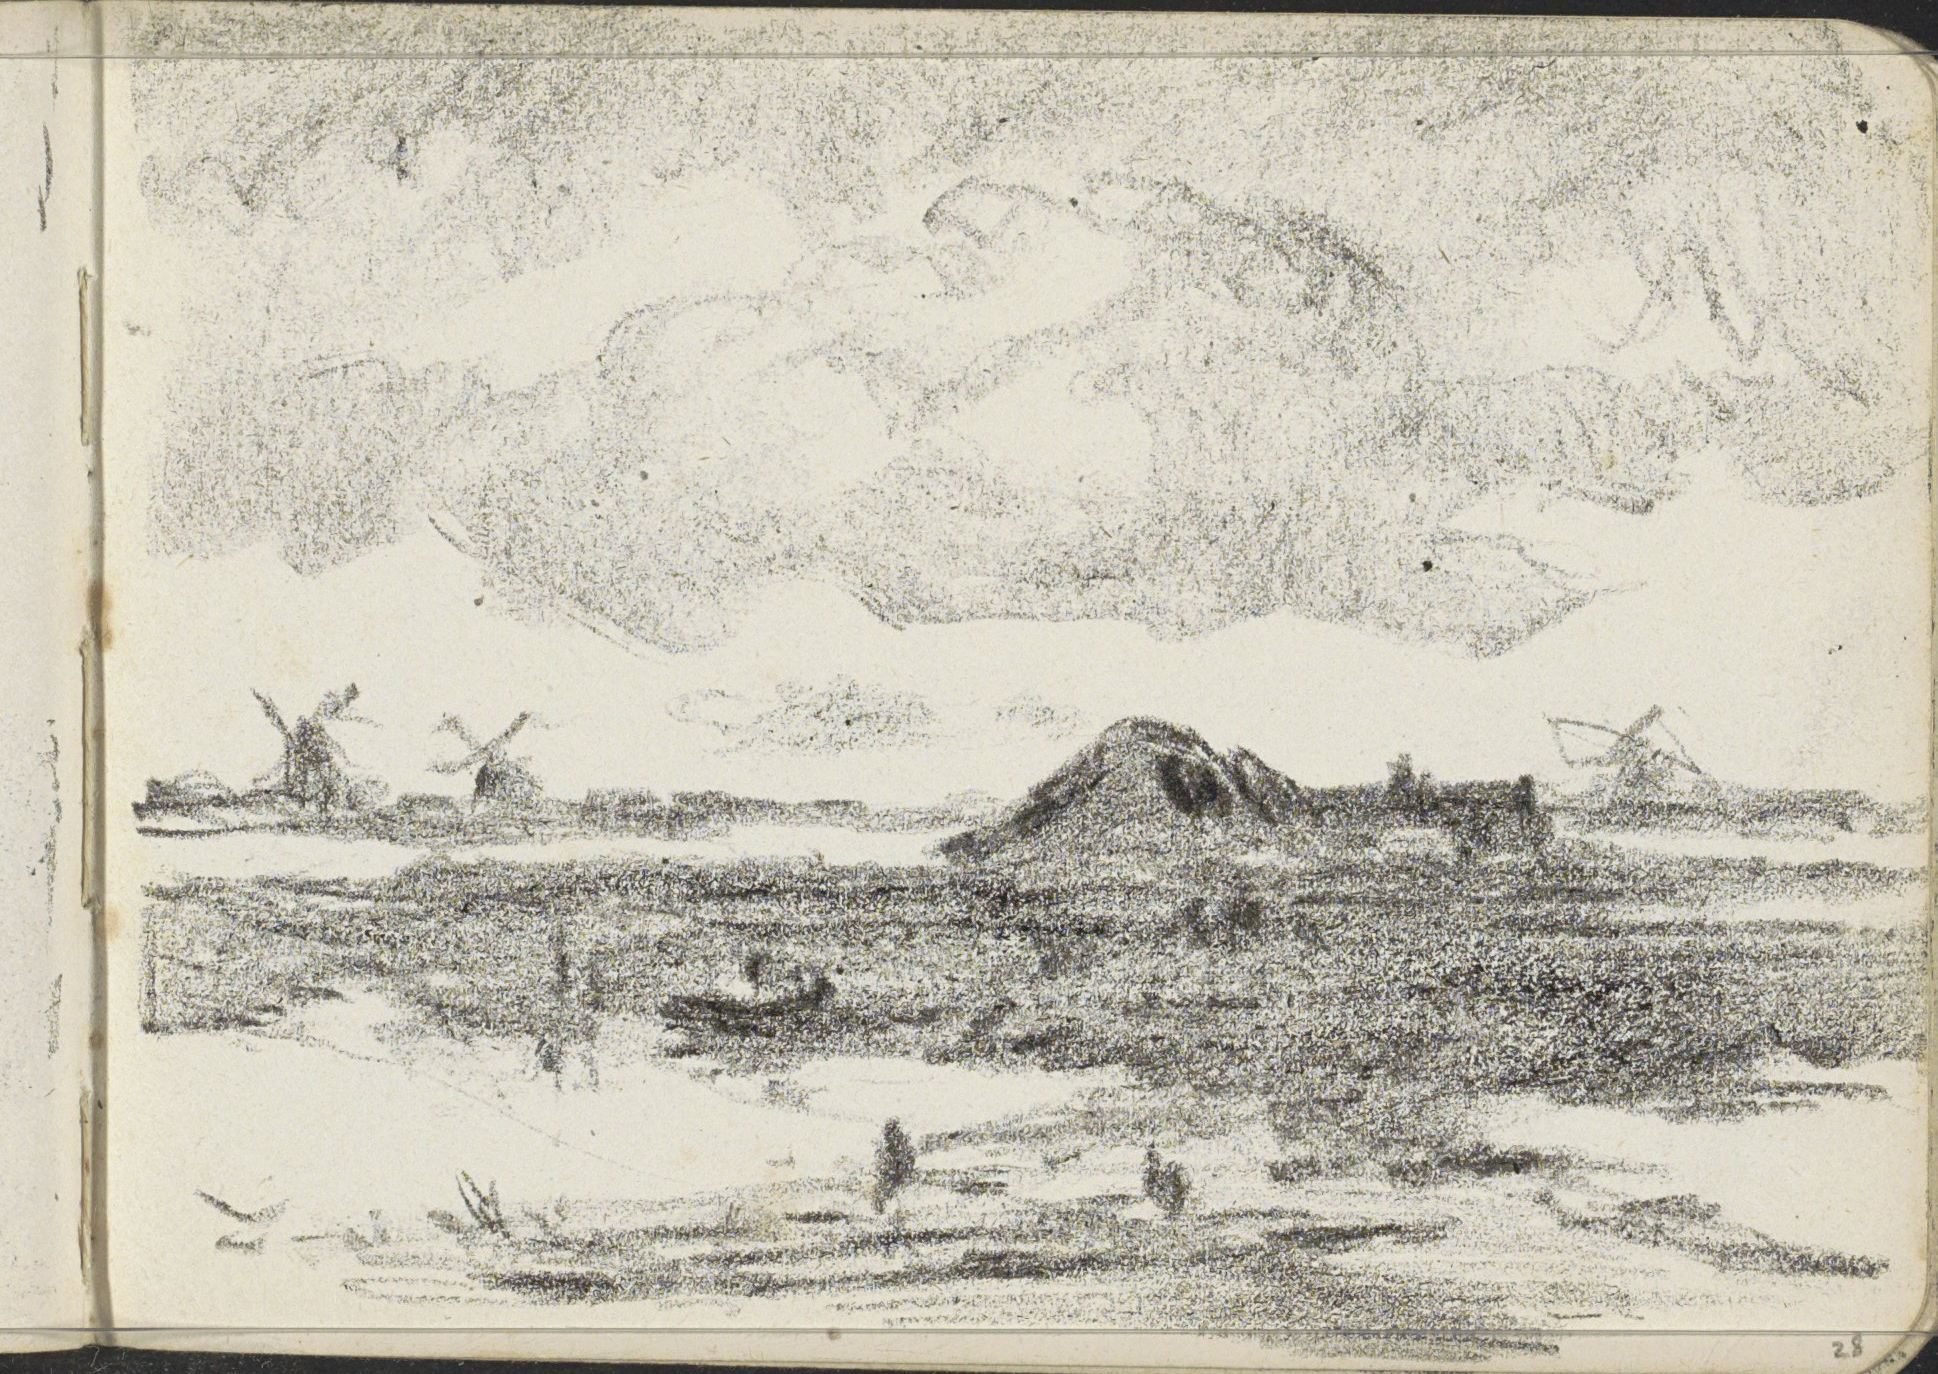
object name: sketchbook leaf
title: Rivierlandschap met molens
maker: willem cornelis rip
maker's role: draughtsman, painter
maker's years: 1856-1922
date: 1907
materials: chalk, paper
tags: landscapes with waters, waterscapes, seascapes (in the temperate zone), windmill in landscape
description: Blad 28 recto uit een schetsboek met 41 bladen.